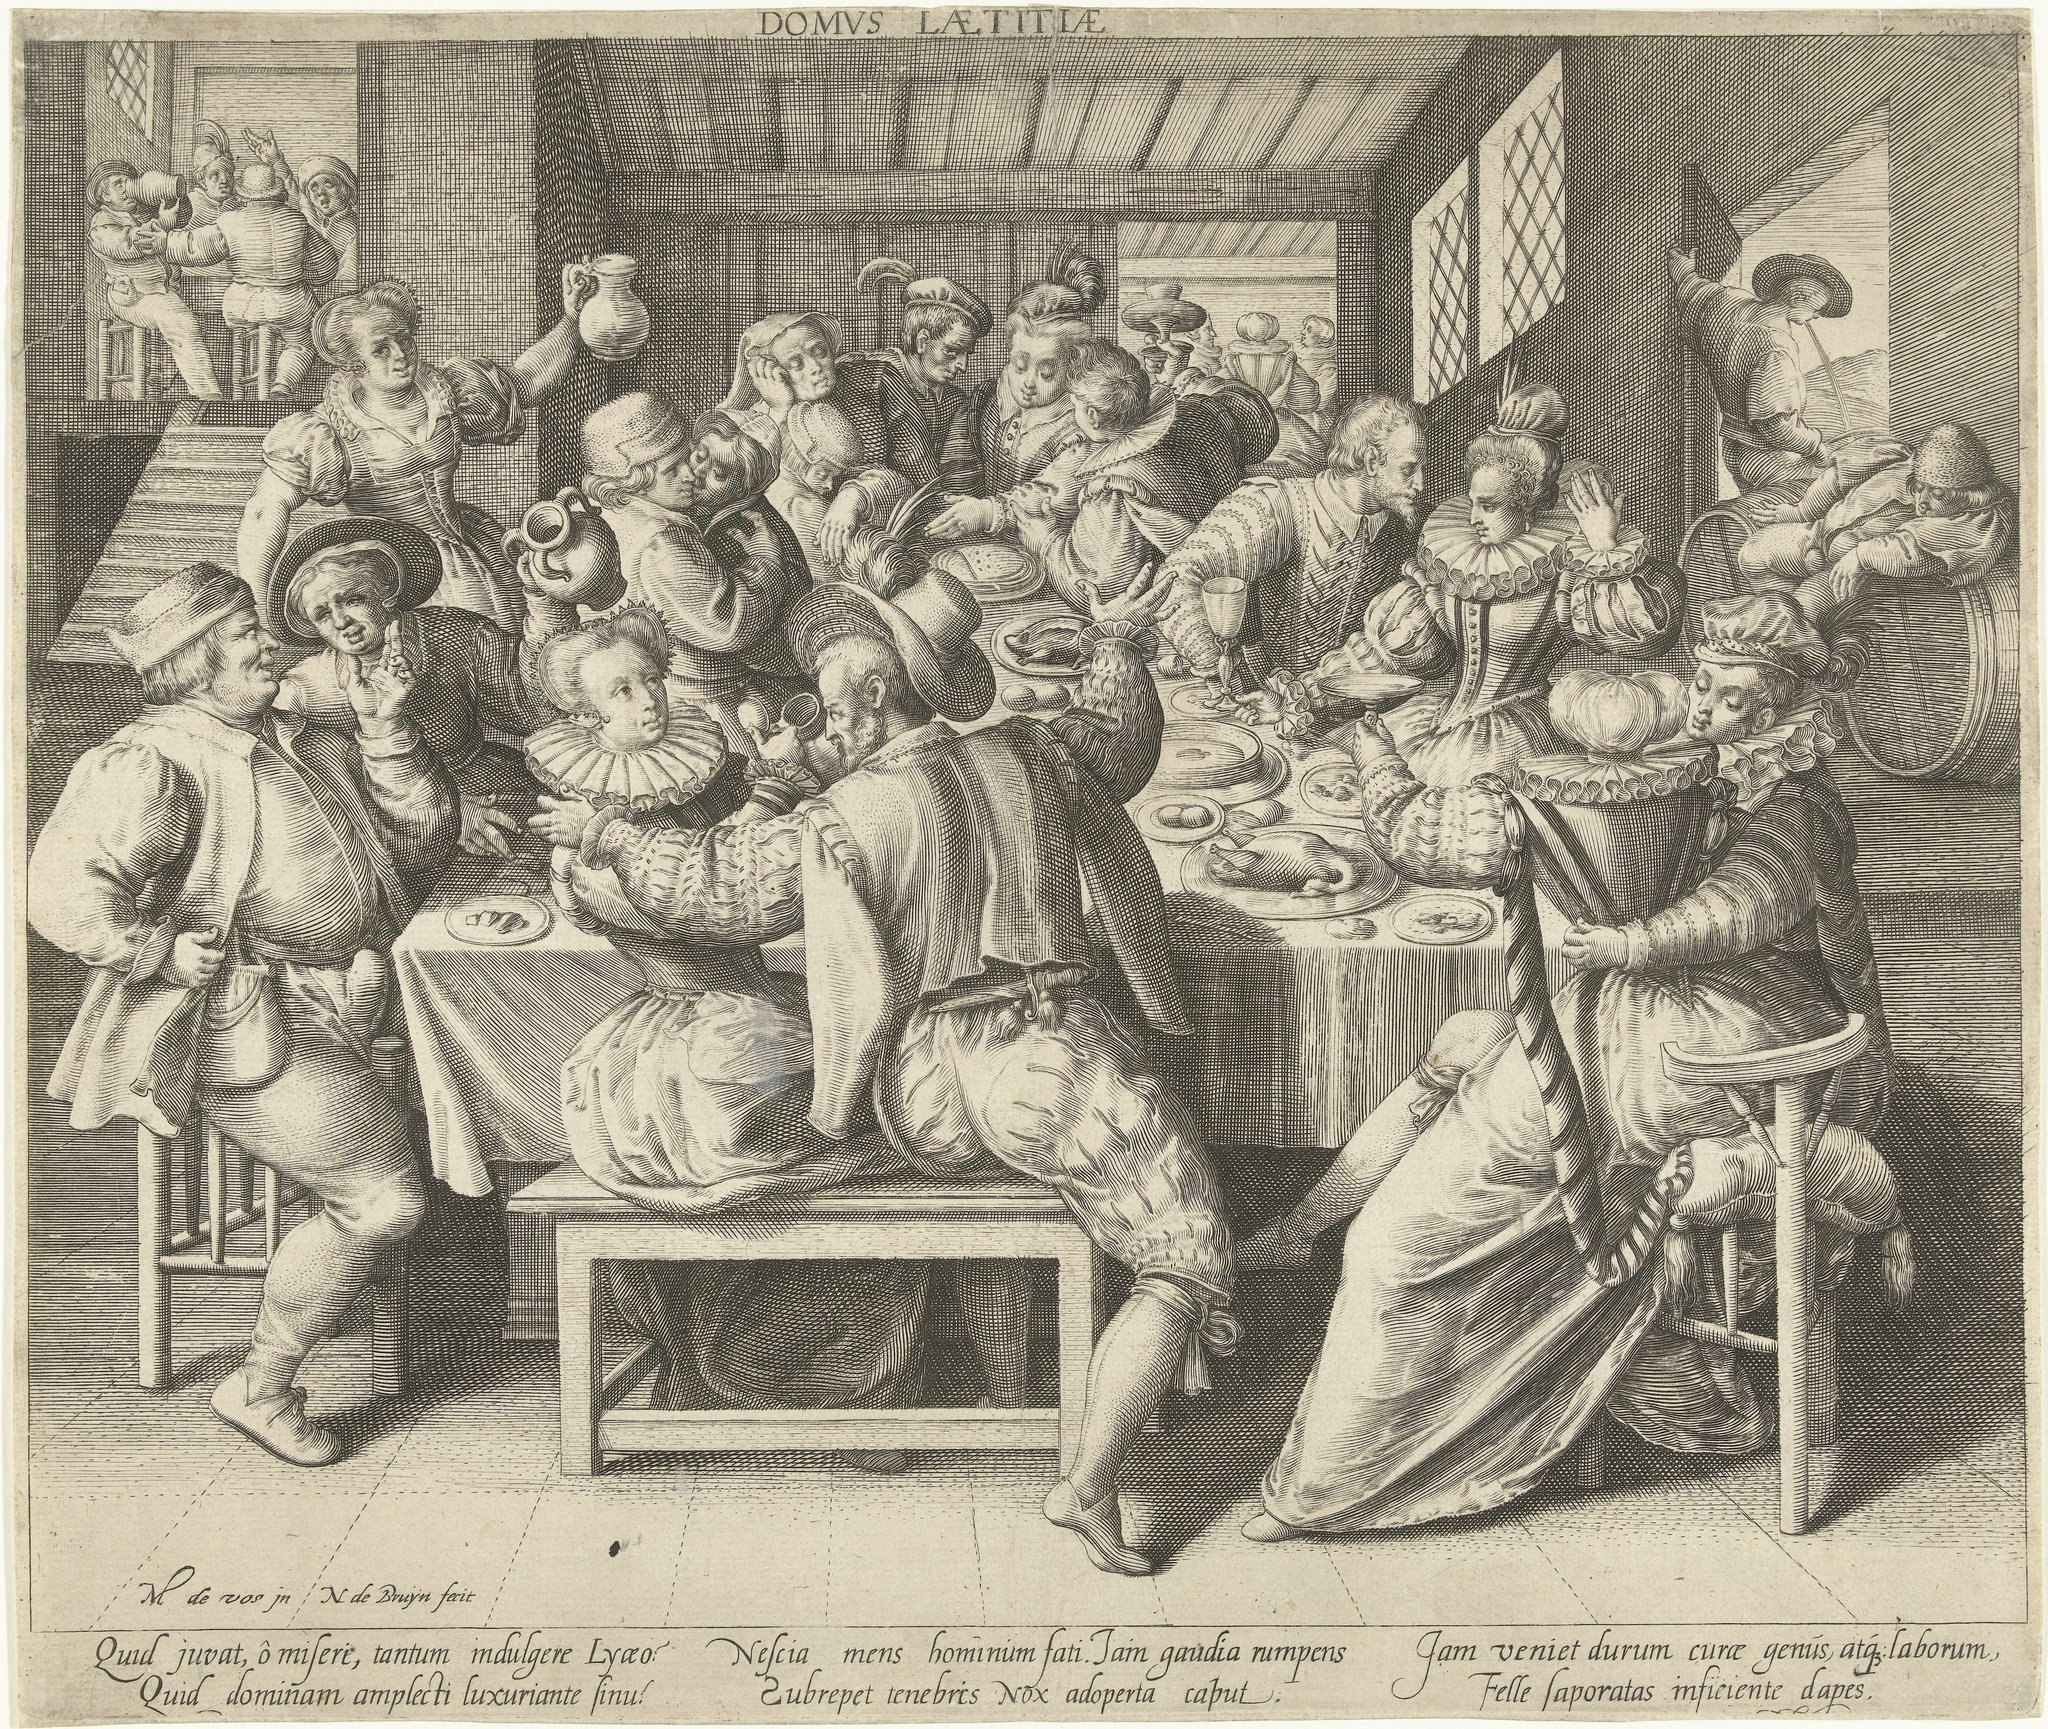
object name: print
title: Een huis vol feestrumoer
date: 1581-1656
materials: paper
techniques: engraving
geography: netherlands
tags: drunkenness, mother and baby or young child, courting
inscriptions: collector's mark: Lugt 2228, collector's mark: Lugt 2004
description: Verbeelding van één van de wijsheden volgens het boek Prediker (nr. 7). In een interieur zit een feestend en vrijend gezelschap van mannen en vrouwen aan een tafel die vol staat met lekkernijen en drank. Volgens Prediker gedragen zij zich dwaas omdat zij genoegen scheppen in een huis vol plezier. In de marge onder een vers met zes regels Latijn.